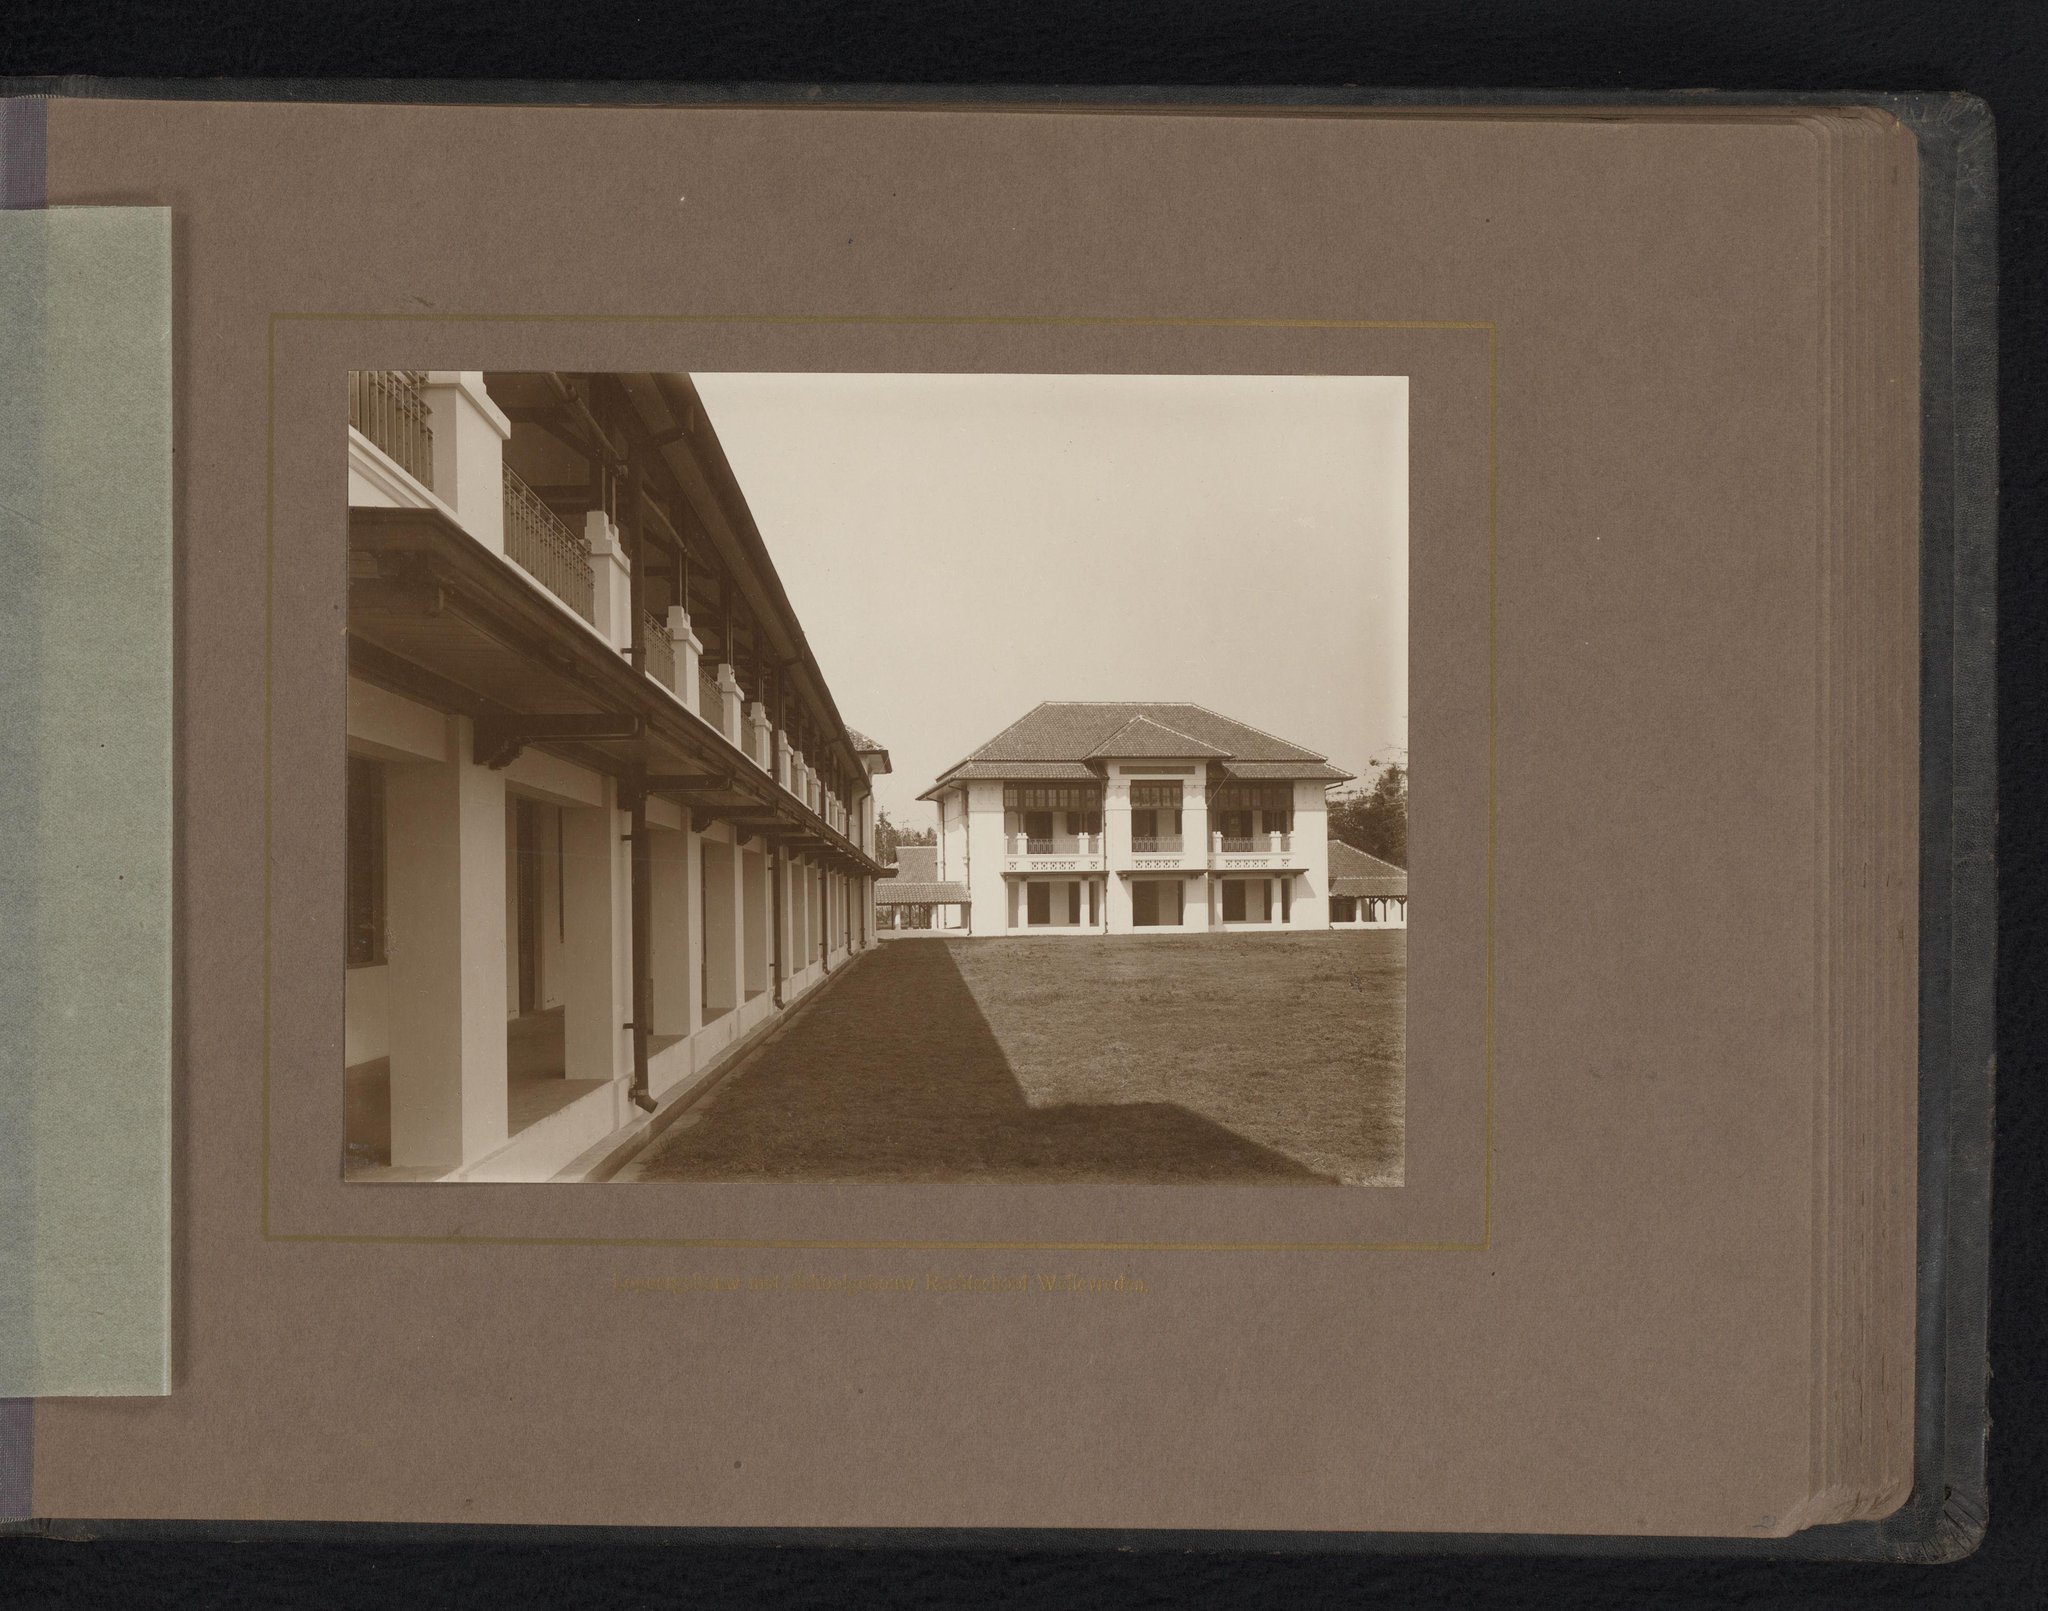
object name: photograph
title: Logeergebouw met Schoolgebouw Rechtschool Weltevreden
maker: Anonymous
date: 1918-1919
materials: photographic support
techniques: gelatin silver print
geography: batavia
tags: further education (+ building ~ education, tuition), batavia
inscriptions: inscription: ‘Logeergebouw met Schoolgebouw Rechtschool Weltevreden’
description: Het logeergebouw en het schoolgebouw bij de Rechtschool te Weltevreden. Onderdeel van het fotoalbum van de Eerste Waterstaatsafdeling op West-Java 22 maart 1915 - 30 juli 1919.